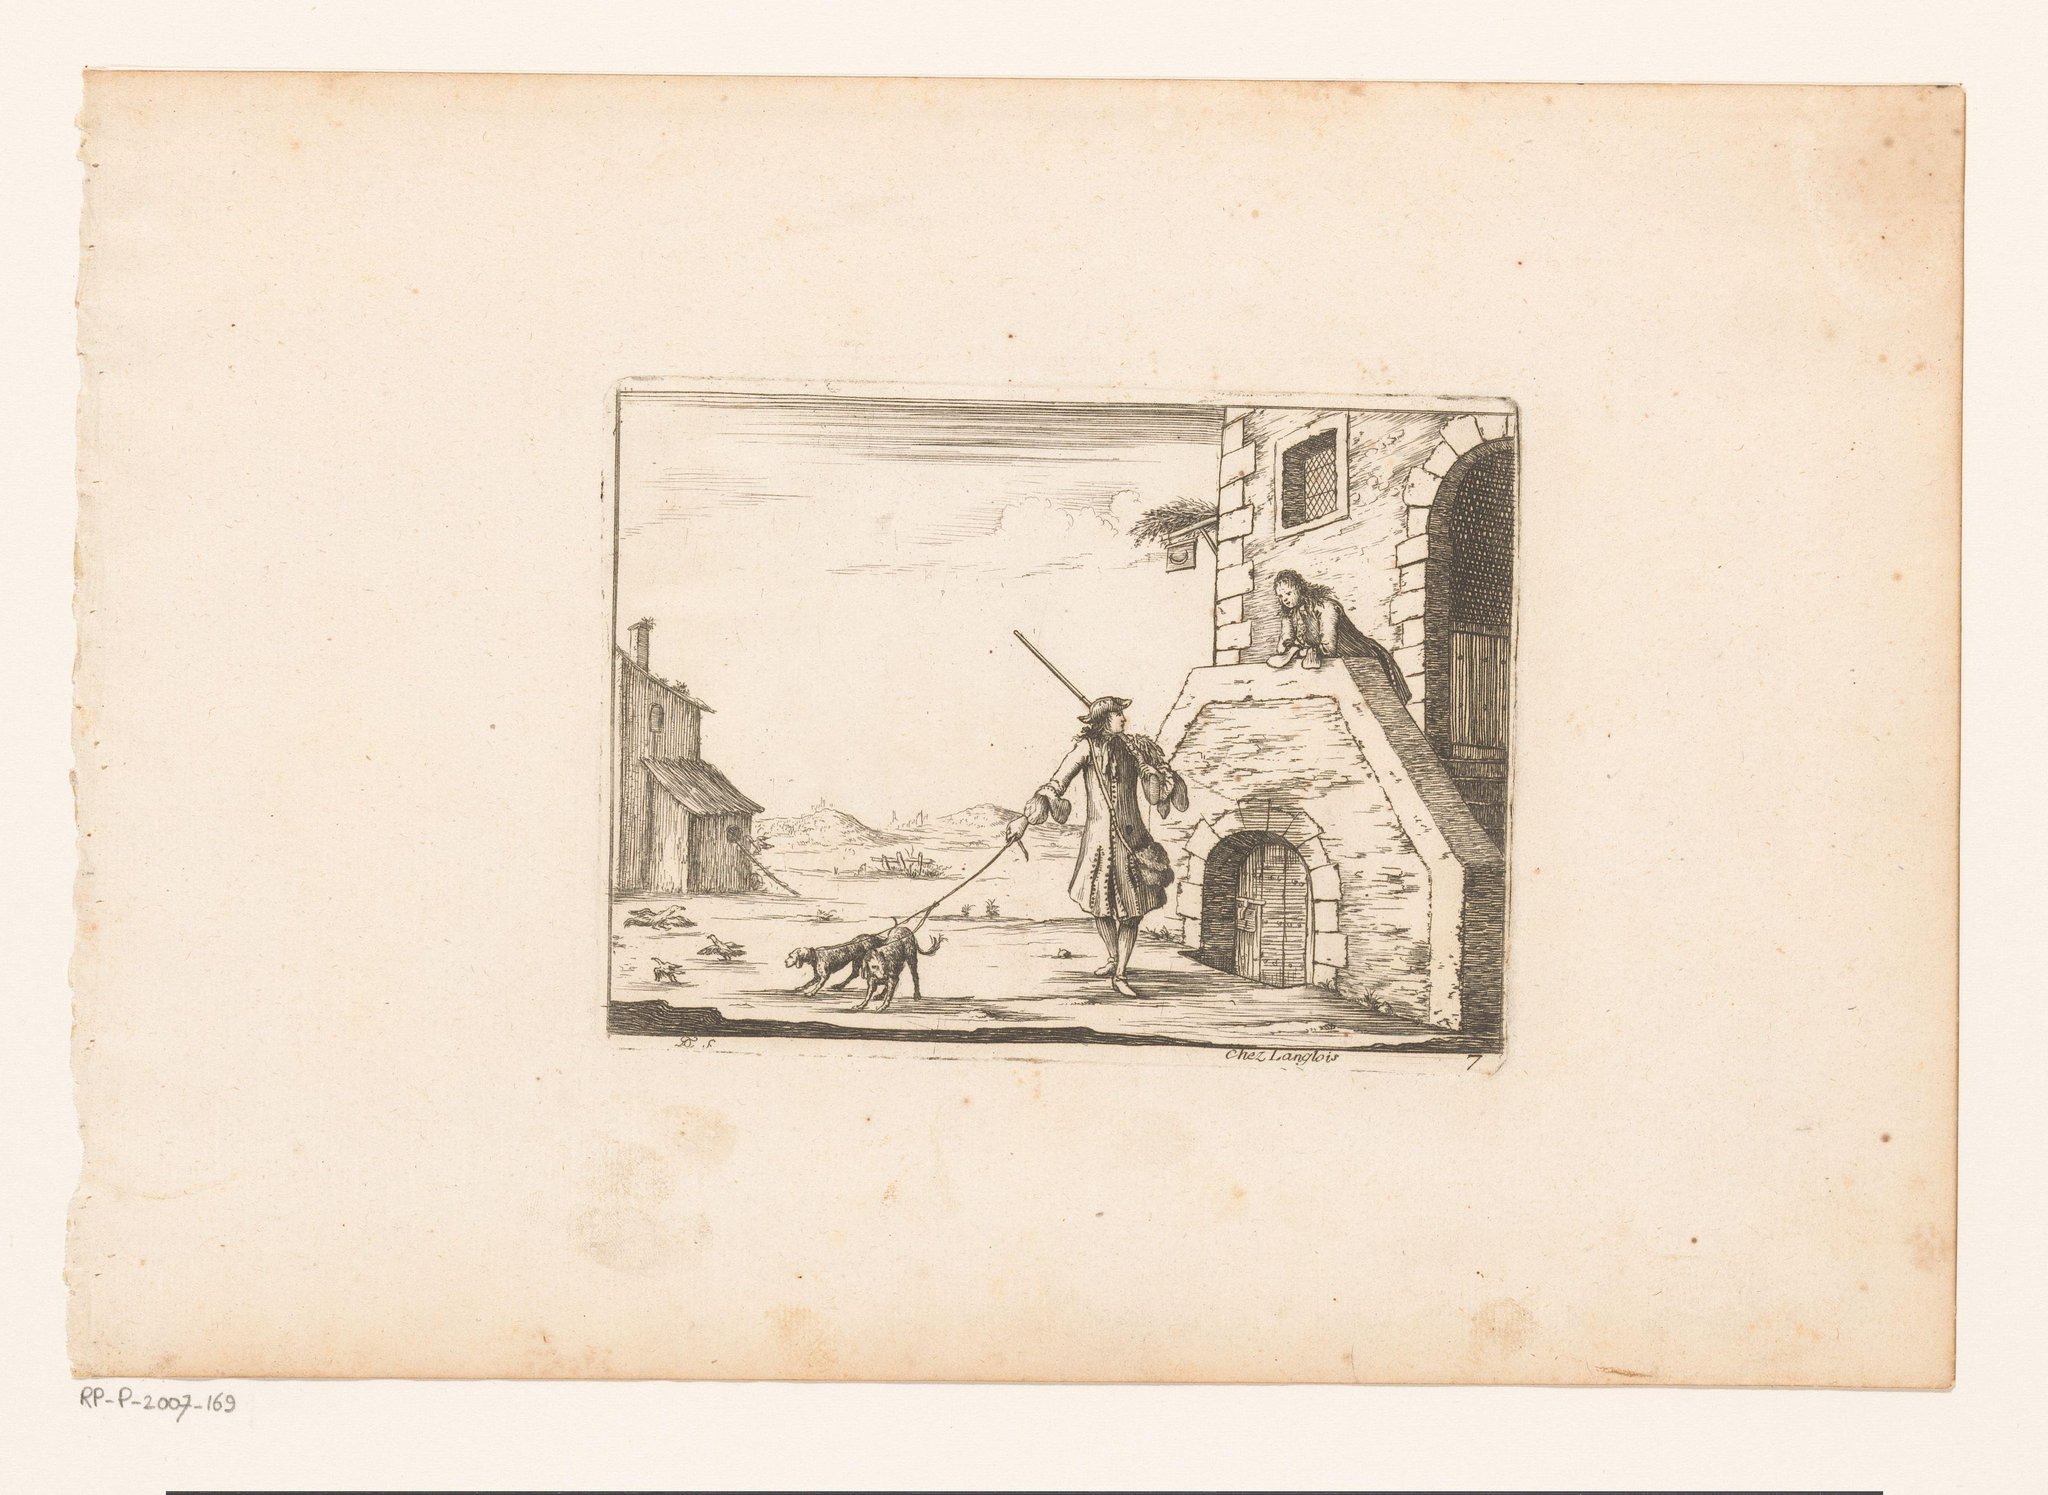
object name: print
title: Jager met geweer en jachthonden voor een huis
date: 1670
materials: paper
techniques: etching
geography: paris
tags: hunting dogs, hunter, firearms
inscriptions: collector's mark: Lugt 2228, collector's mark: Lugt 2760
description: Maakt deel uit van een serie van twaalf prenten met verschillende figuren, uitgegeven door Langlois in Parijs.